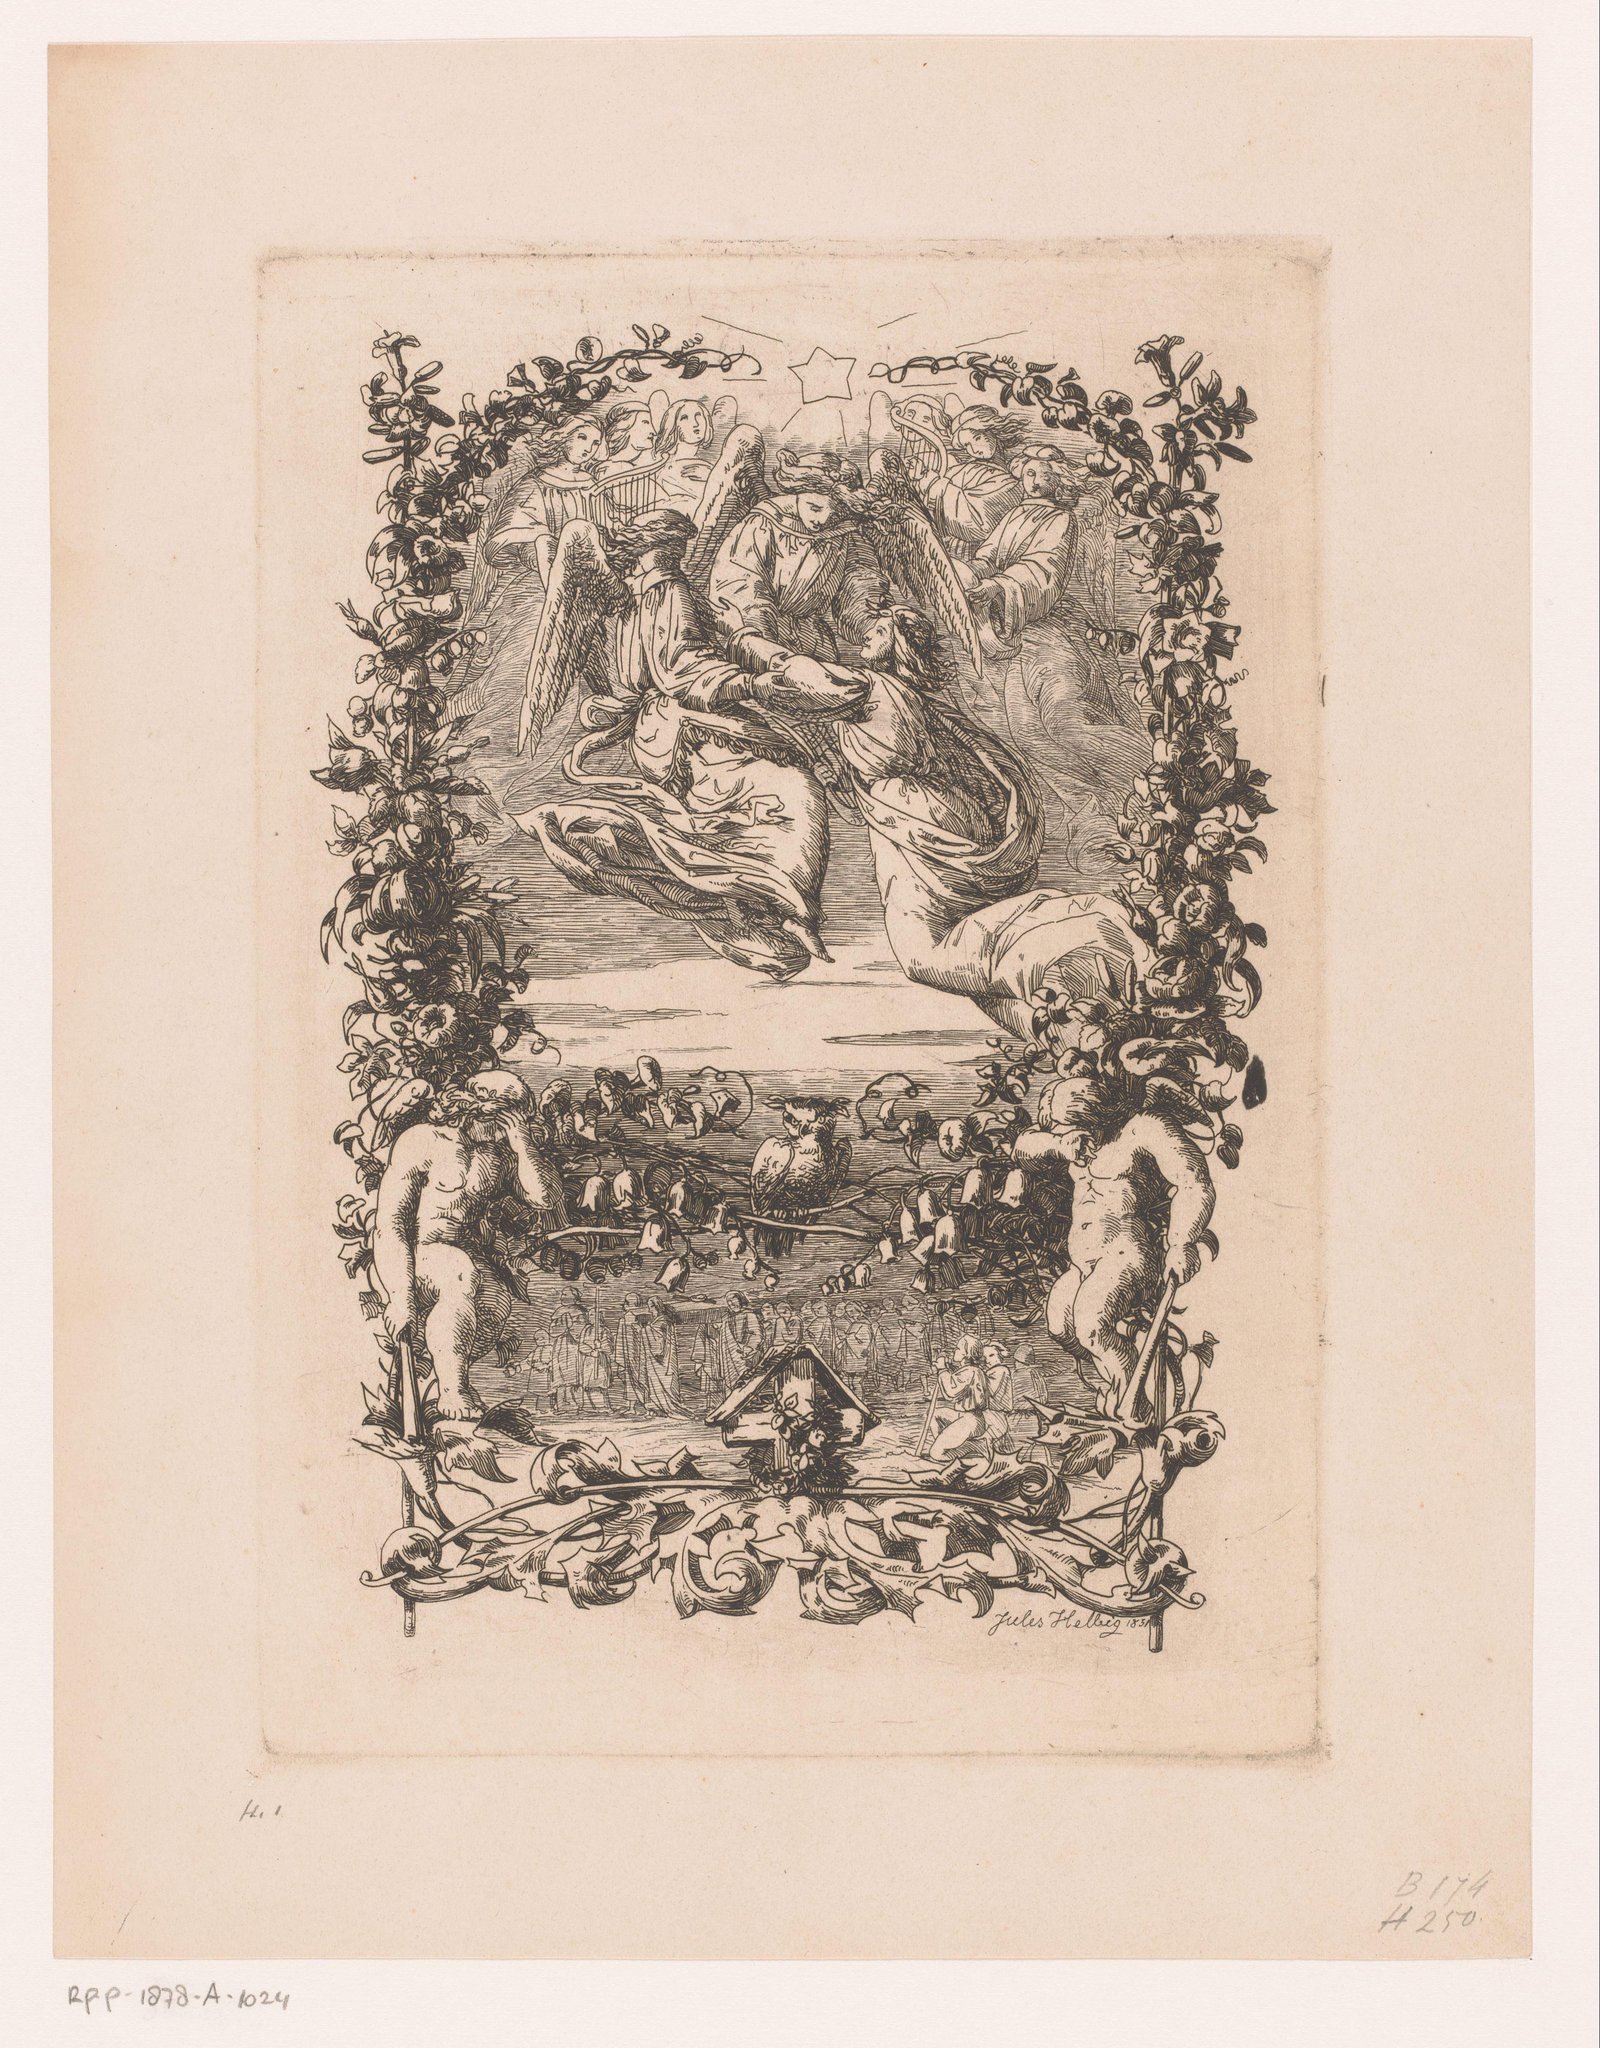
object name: print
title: Engelen nemen een ziel op in de hemel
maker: jules chrétien charles joseph henri helbig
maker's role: painter, print maker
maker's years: 1821-1906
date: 1851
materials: paper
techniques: etching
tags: cortege, funeral procession, owls, apotheosis (or ascension) of individuals, angels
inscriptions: collector's mark: Lugt 2228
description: In een kader van plantenmotieven zijn twee voorstellingen afgebeeld. Onder een begrafenisstoet en boven een ten hemelopneming.